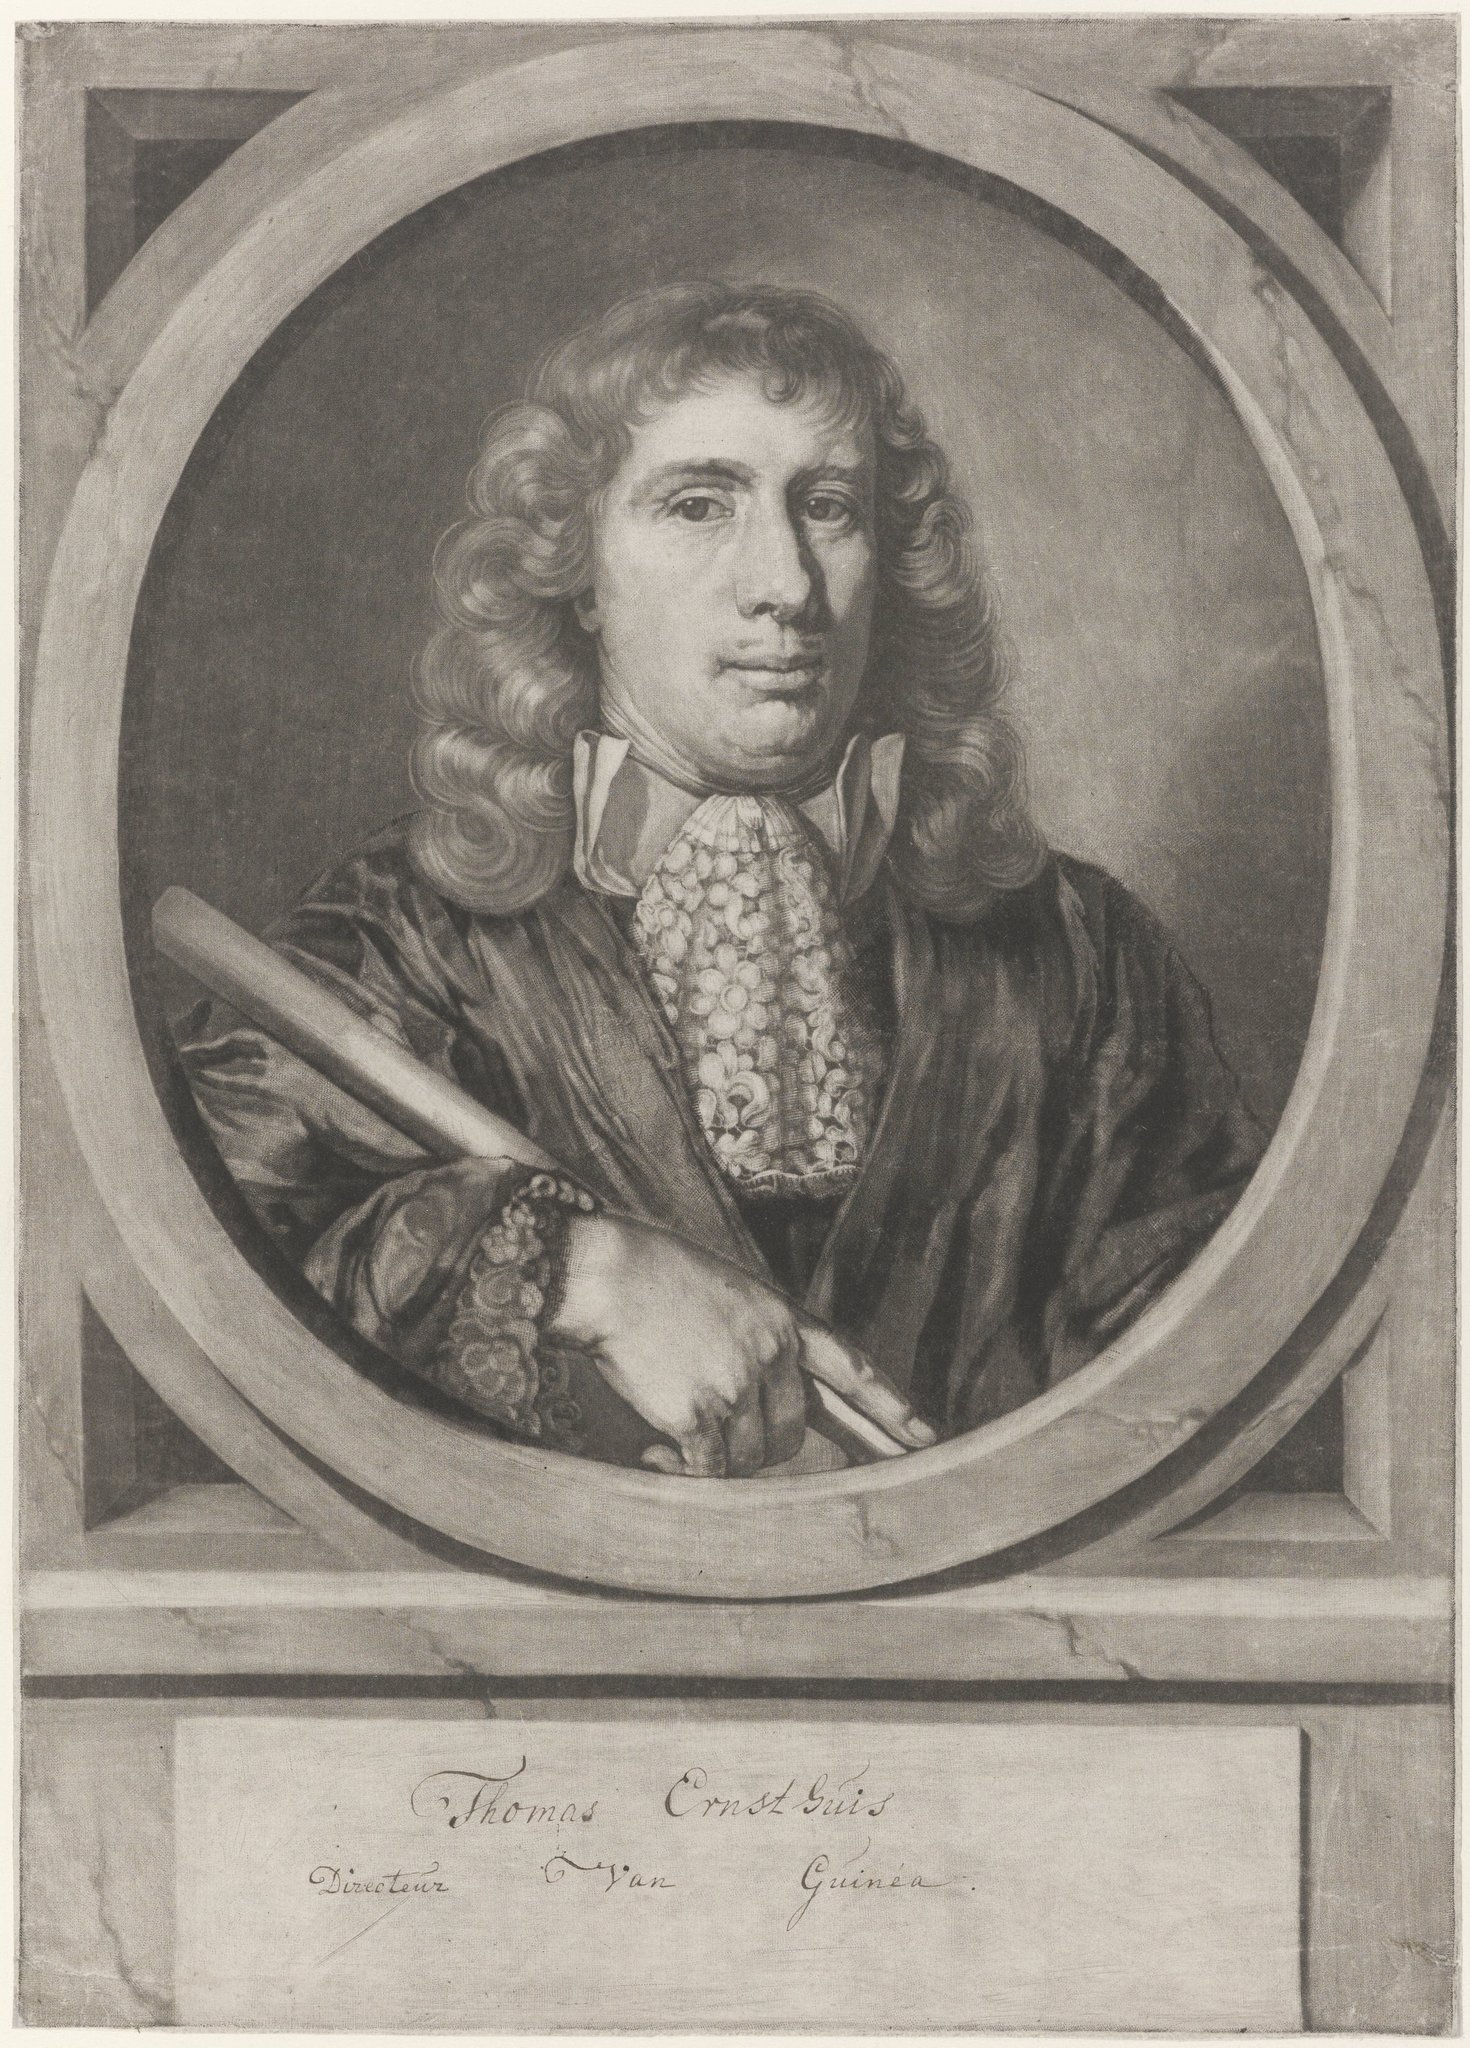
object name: print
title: Portret van Thomas Ernsthuys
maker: abraham bloteling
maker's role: draughtsman, print maker, publisher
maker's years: 1640-1690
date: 1684-1690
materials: paper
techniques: mezzotint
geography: amsterdam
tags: guinea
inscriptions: collector's mark: Lugt 2228, inscription: ‘Thomas Ernsthuis / Directeur Van Guinea’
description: Portret van Thomas Ernsthuys, directeur-generaal van de West-Indische Compagnie, ter gelegenheid van zijn overlijden. Hij heeft in de rechterhand een staf.